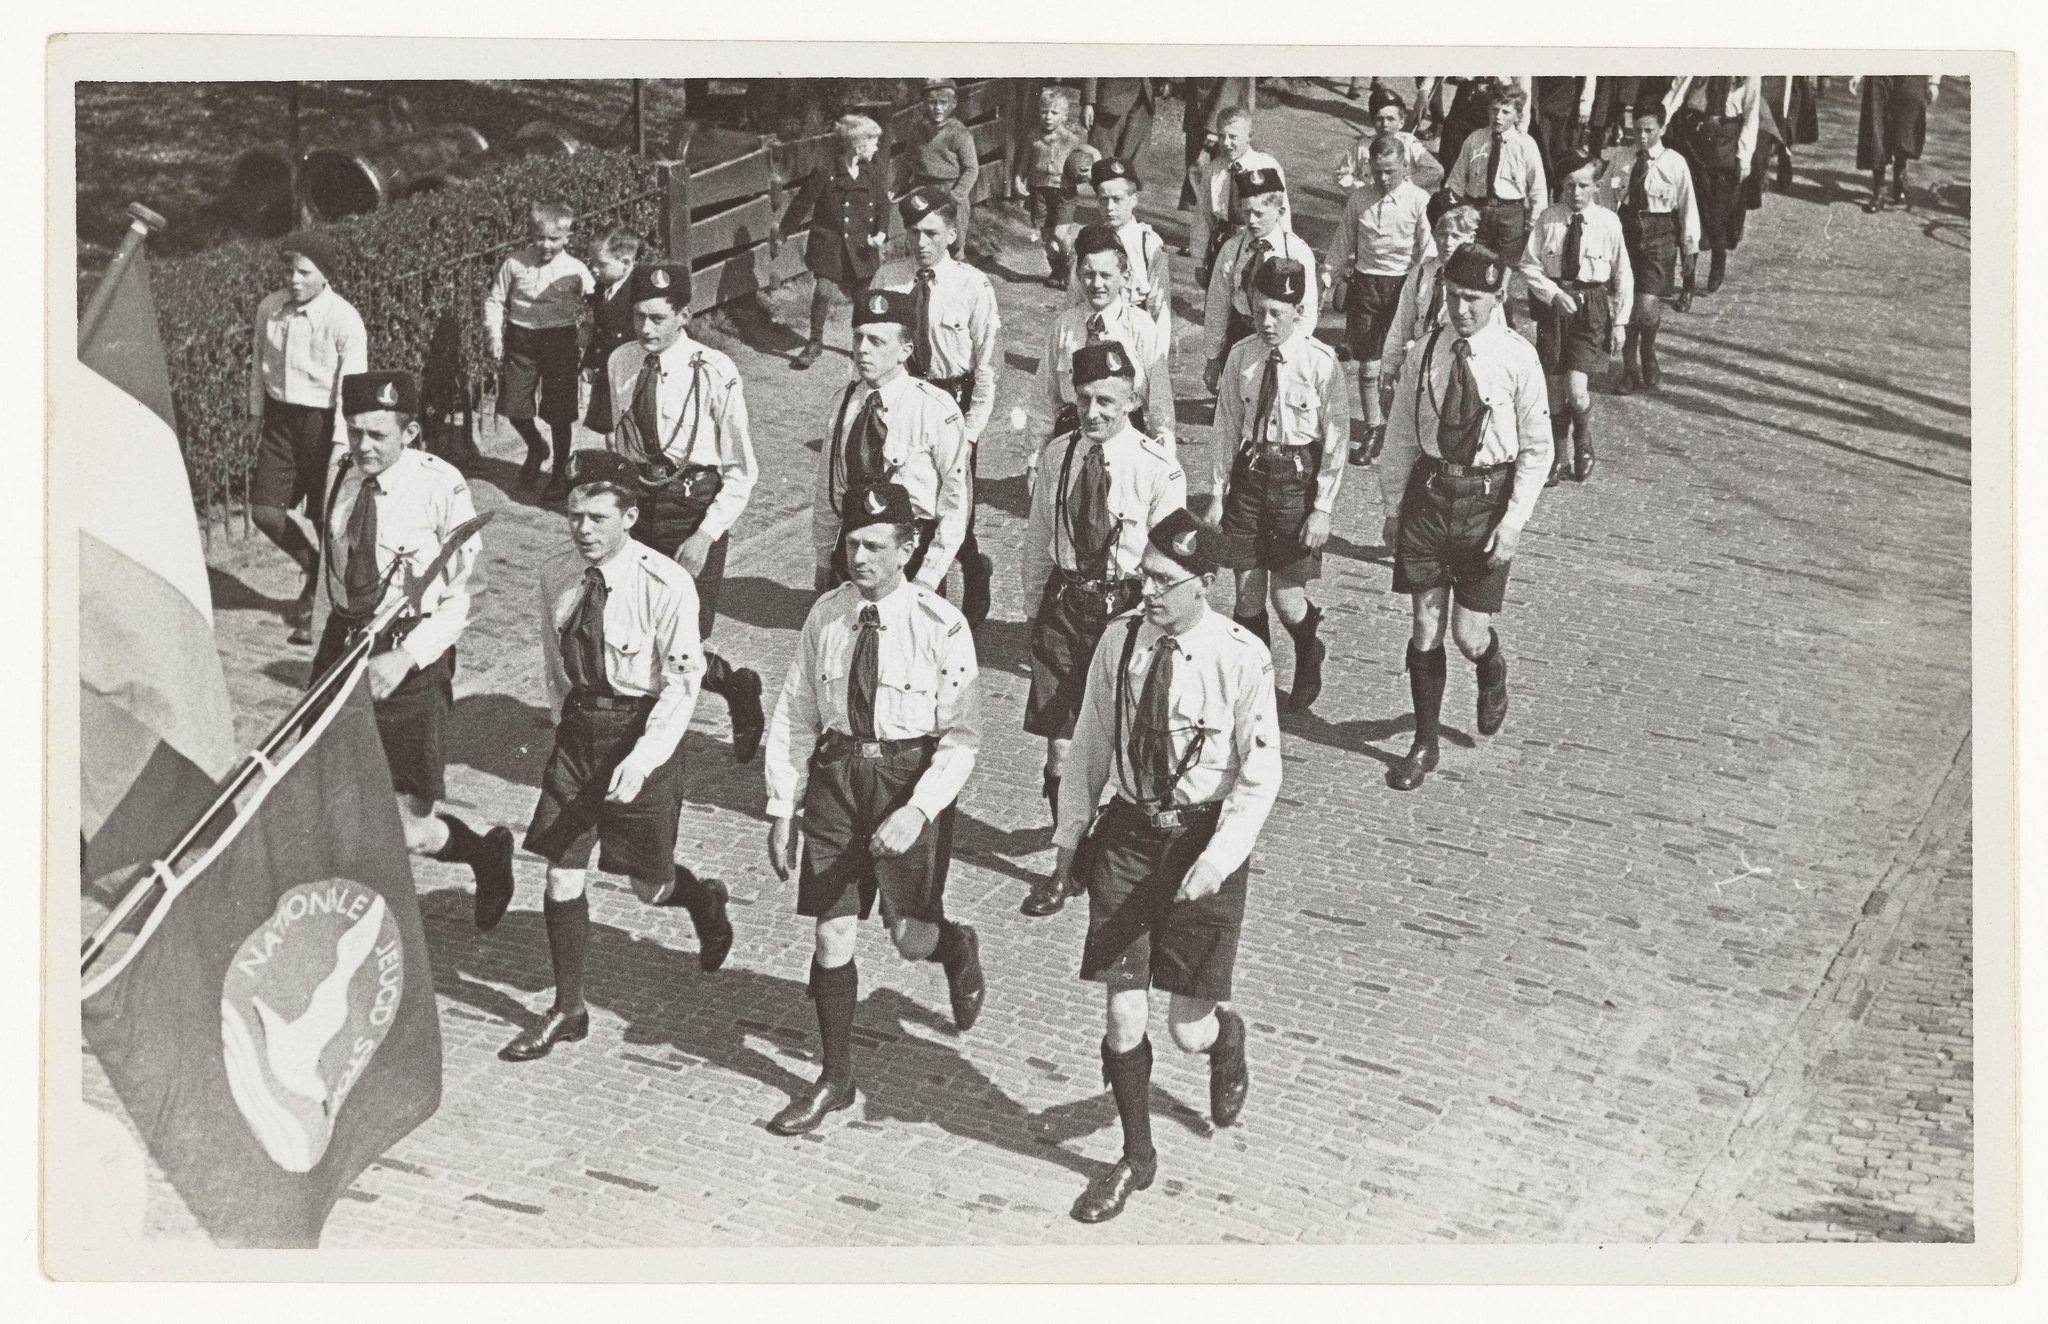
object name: photograph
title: Optocht Jeugdstorm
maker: j. otto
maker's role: fotograaf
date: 1935-1937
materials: photographic support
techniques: gelatin silver print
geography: zeist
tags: military parade, pageant, zeist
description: Groep van de Jeugdstorm loopt door een straat.Goed zichtbaar de vlag van de Jeugdstorm met bovenop de stok als versiering een vliegende meeuw, daarnaast de Nederlandse vlag. Achter de vlaggen lopen een aantal volwassenen in uniform en wat jongens. Kleine kinderen, links, lopen met de Jeugdstormers mee.